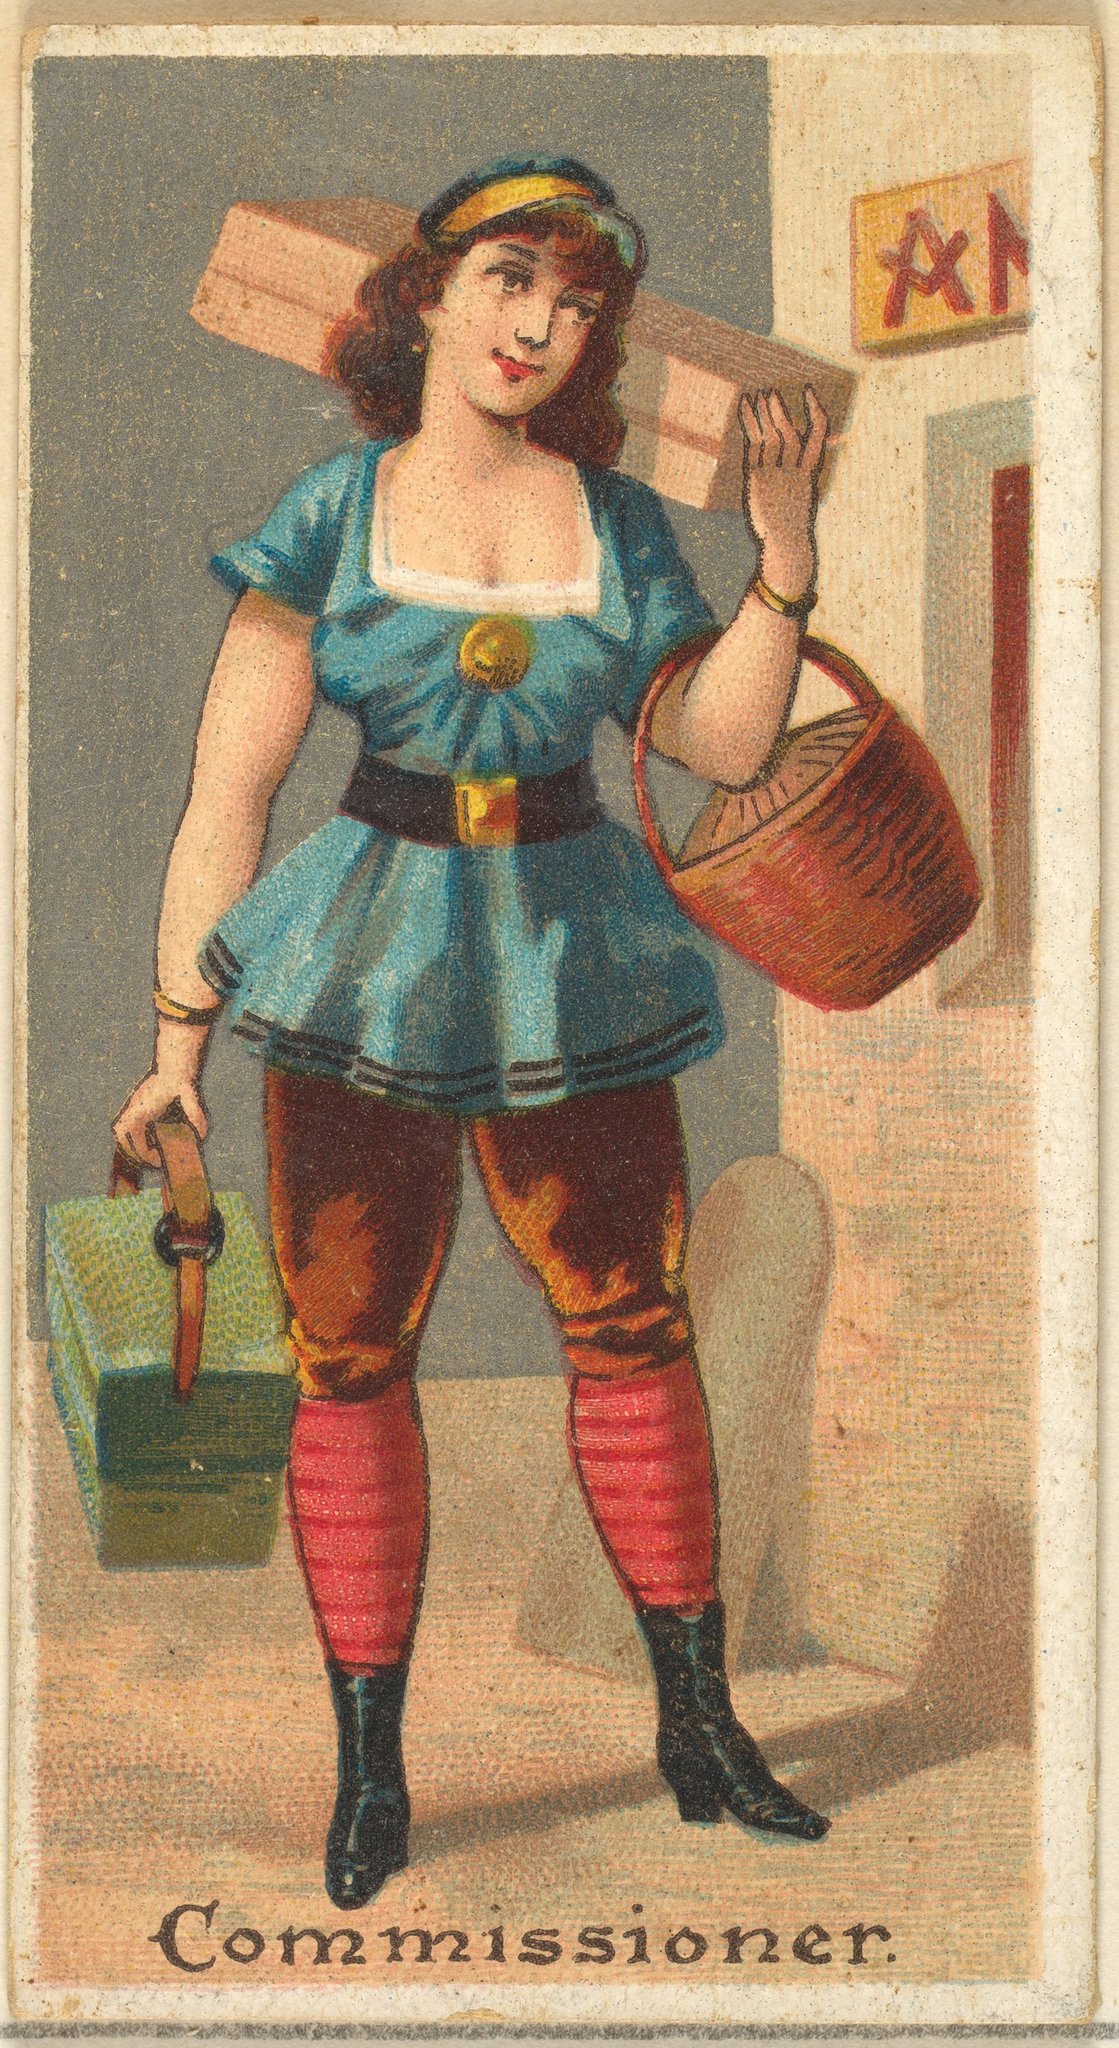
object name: print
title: Commissioner, from the Occupations for Women series (N166) for Old Judge and Dogs Head Cigarettes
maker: goodwin & company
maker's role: publisher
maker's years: 1850-1950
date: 1887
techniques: color lithograph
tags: women